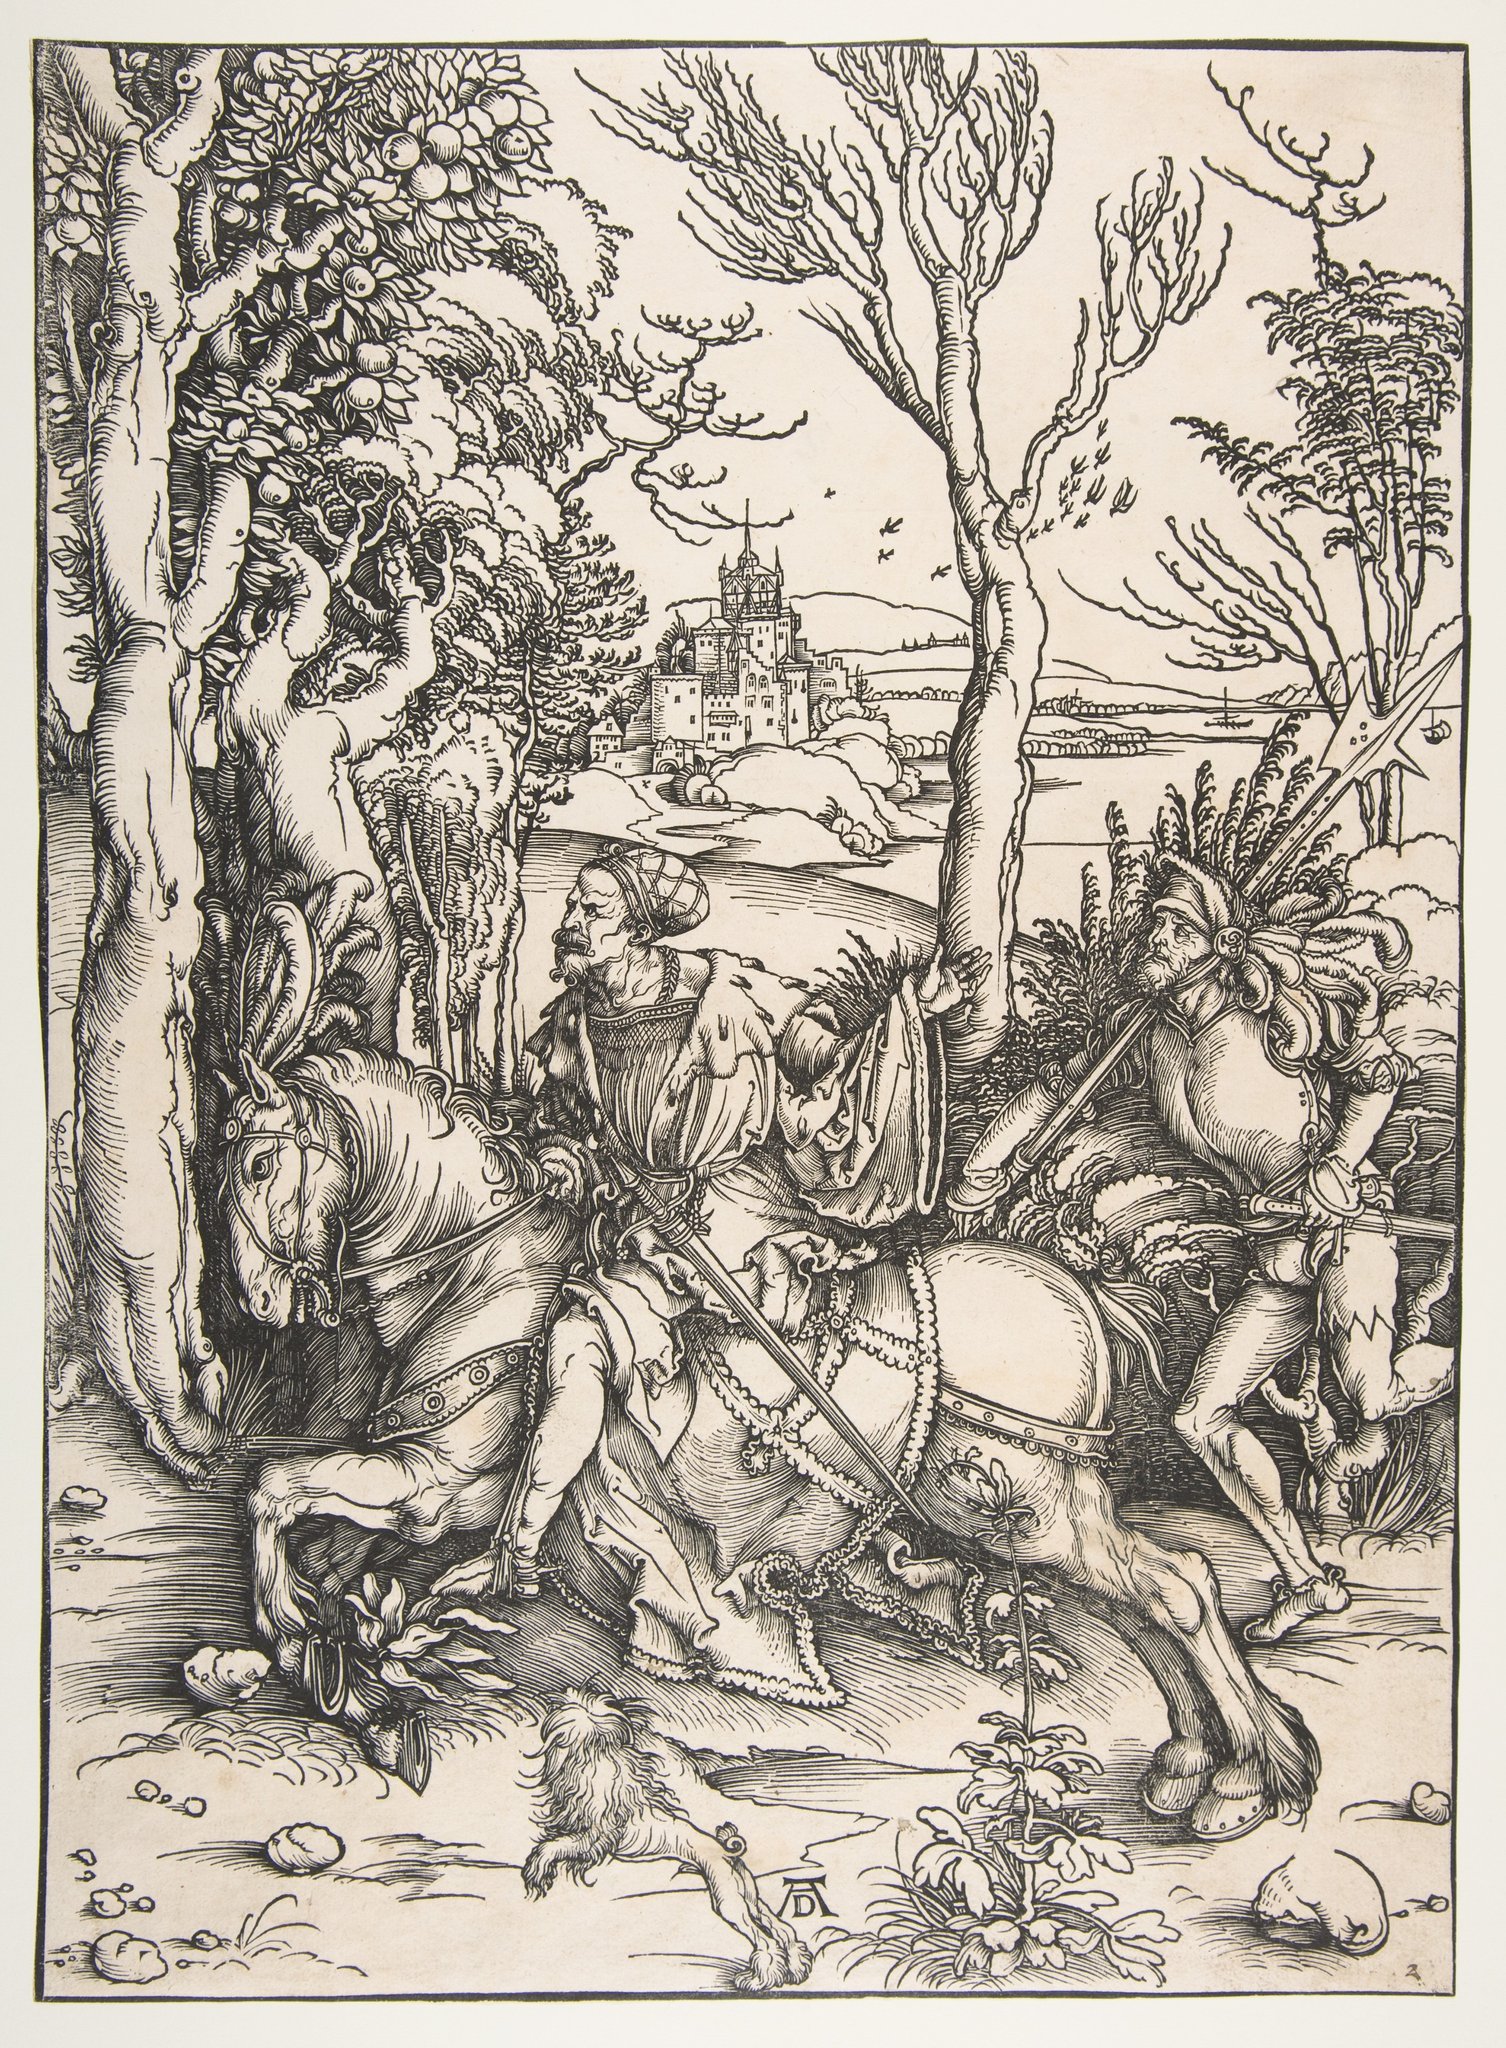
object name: print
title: The Knight on the Horseback with Lansquenet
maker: albrecht dürer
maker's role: artist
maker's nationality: german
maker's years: 1471-1528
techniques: woodcut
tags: animals,men,horses,landscapes,knights